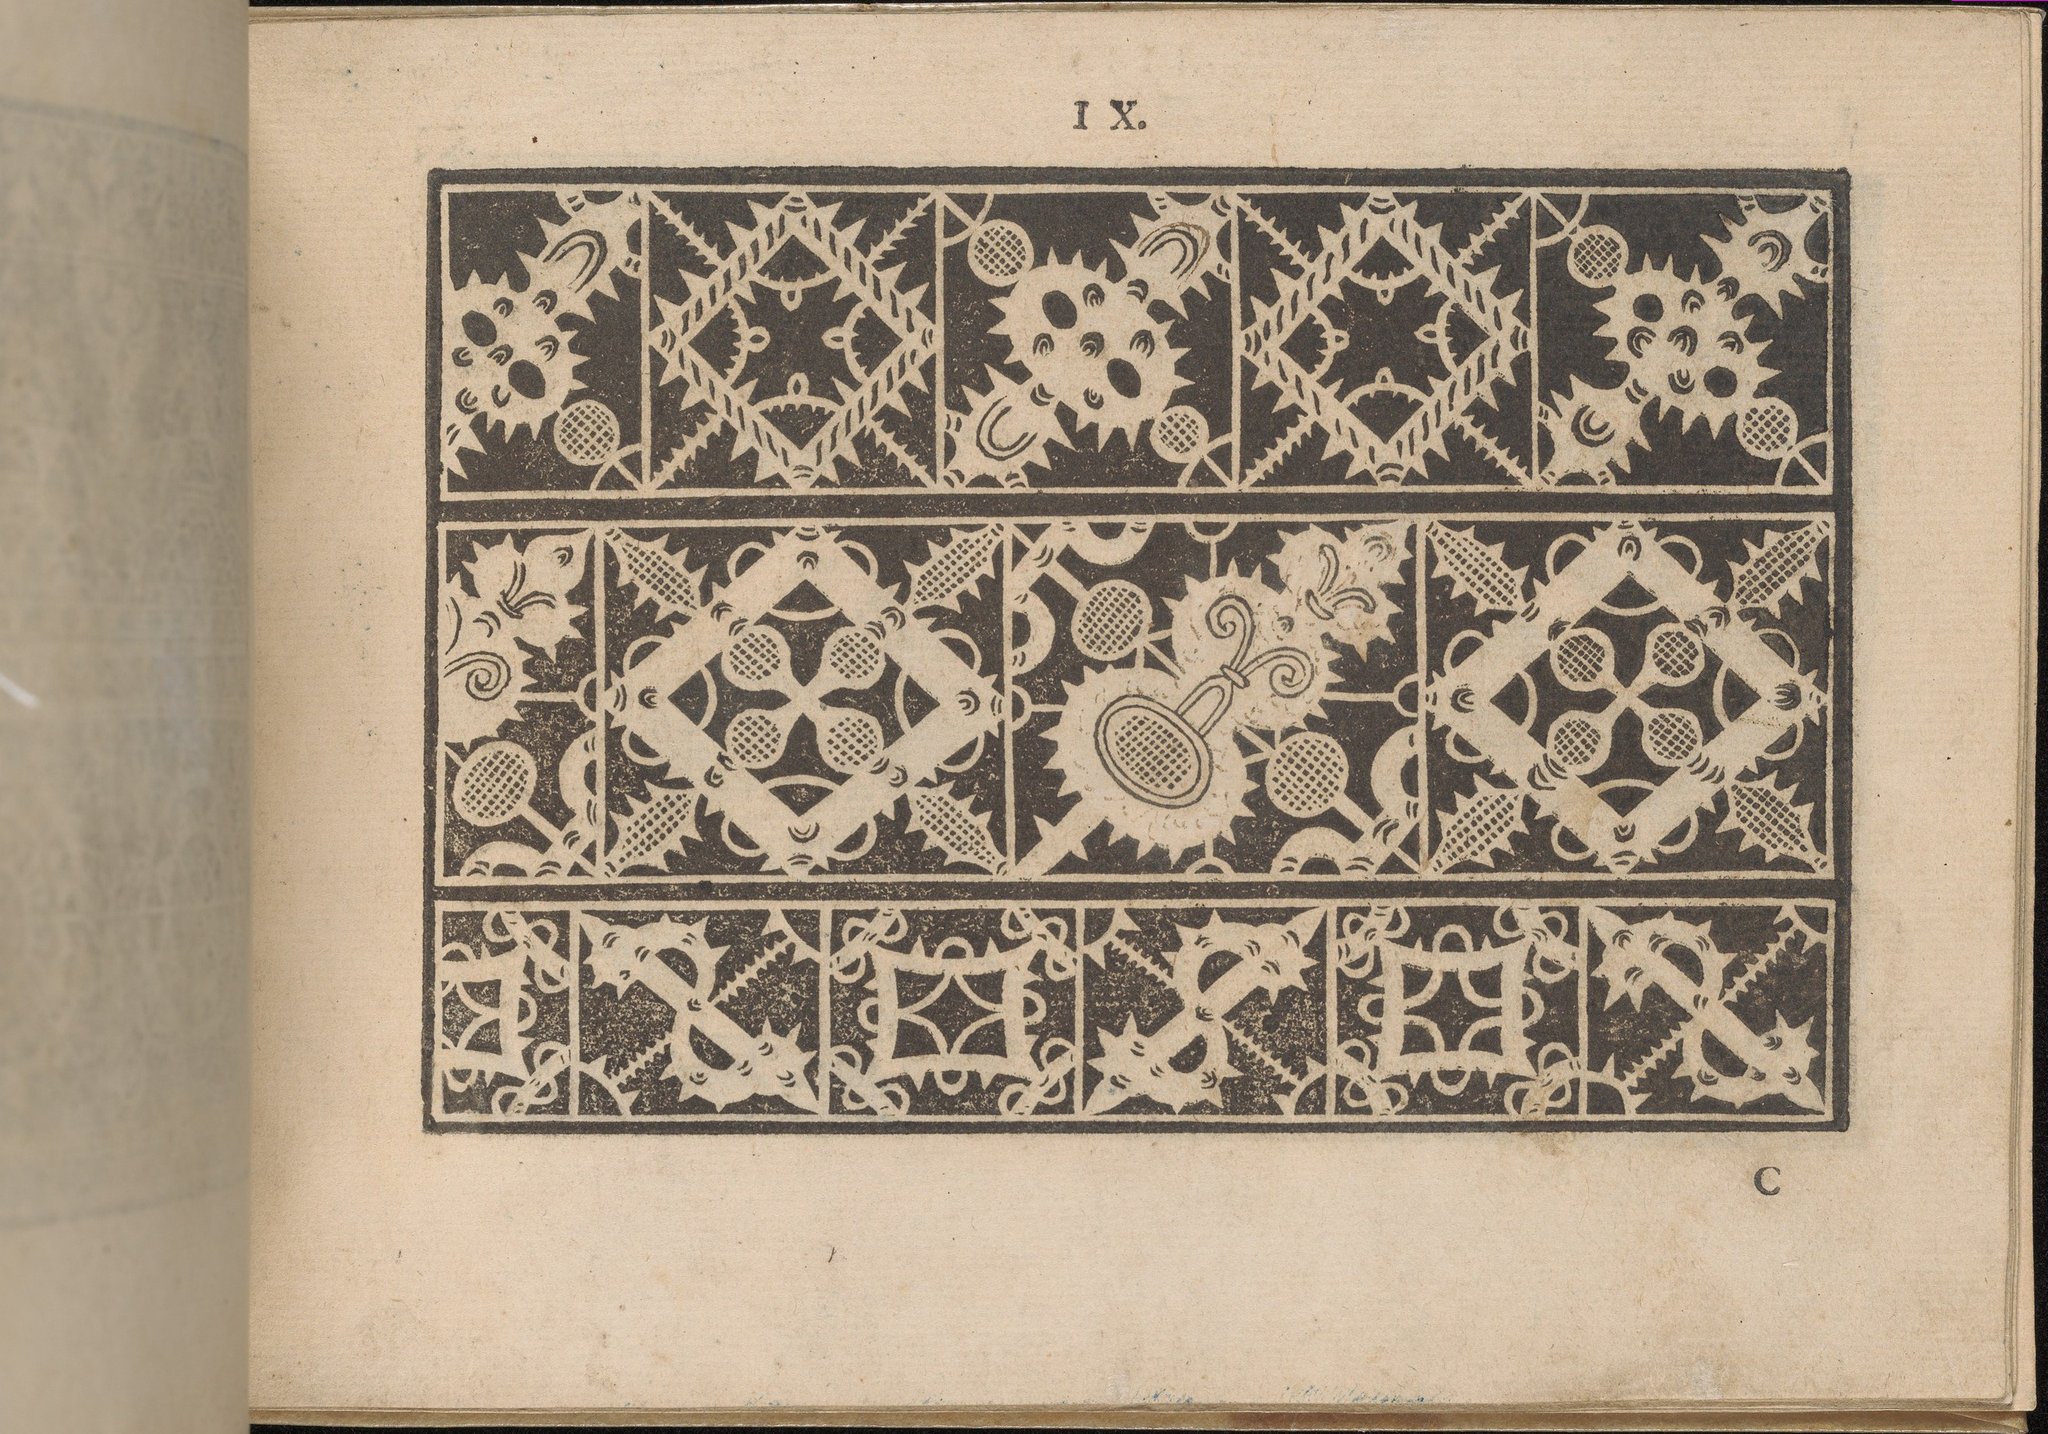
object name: book print ornament architecture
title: Prima Parte de' Fiori, e Disegni di varie sorti di Ricami Moderni, page 9 (recto)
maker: giovanni battista ciotti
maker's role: author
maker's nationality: italian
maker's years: 1555-1659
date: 1591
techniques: woodcut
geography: italy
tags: ornament